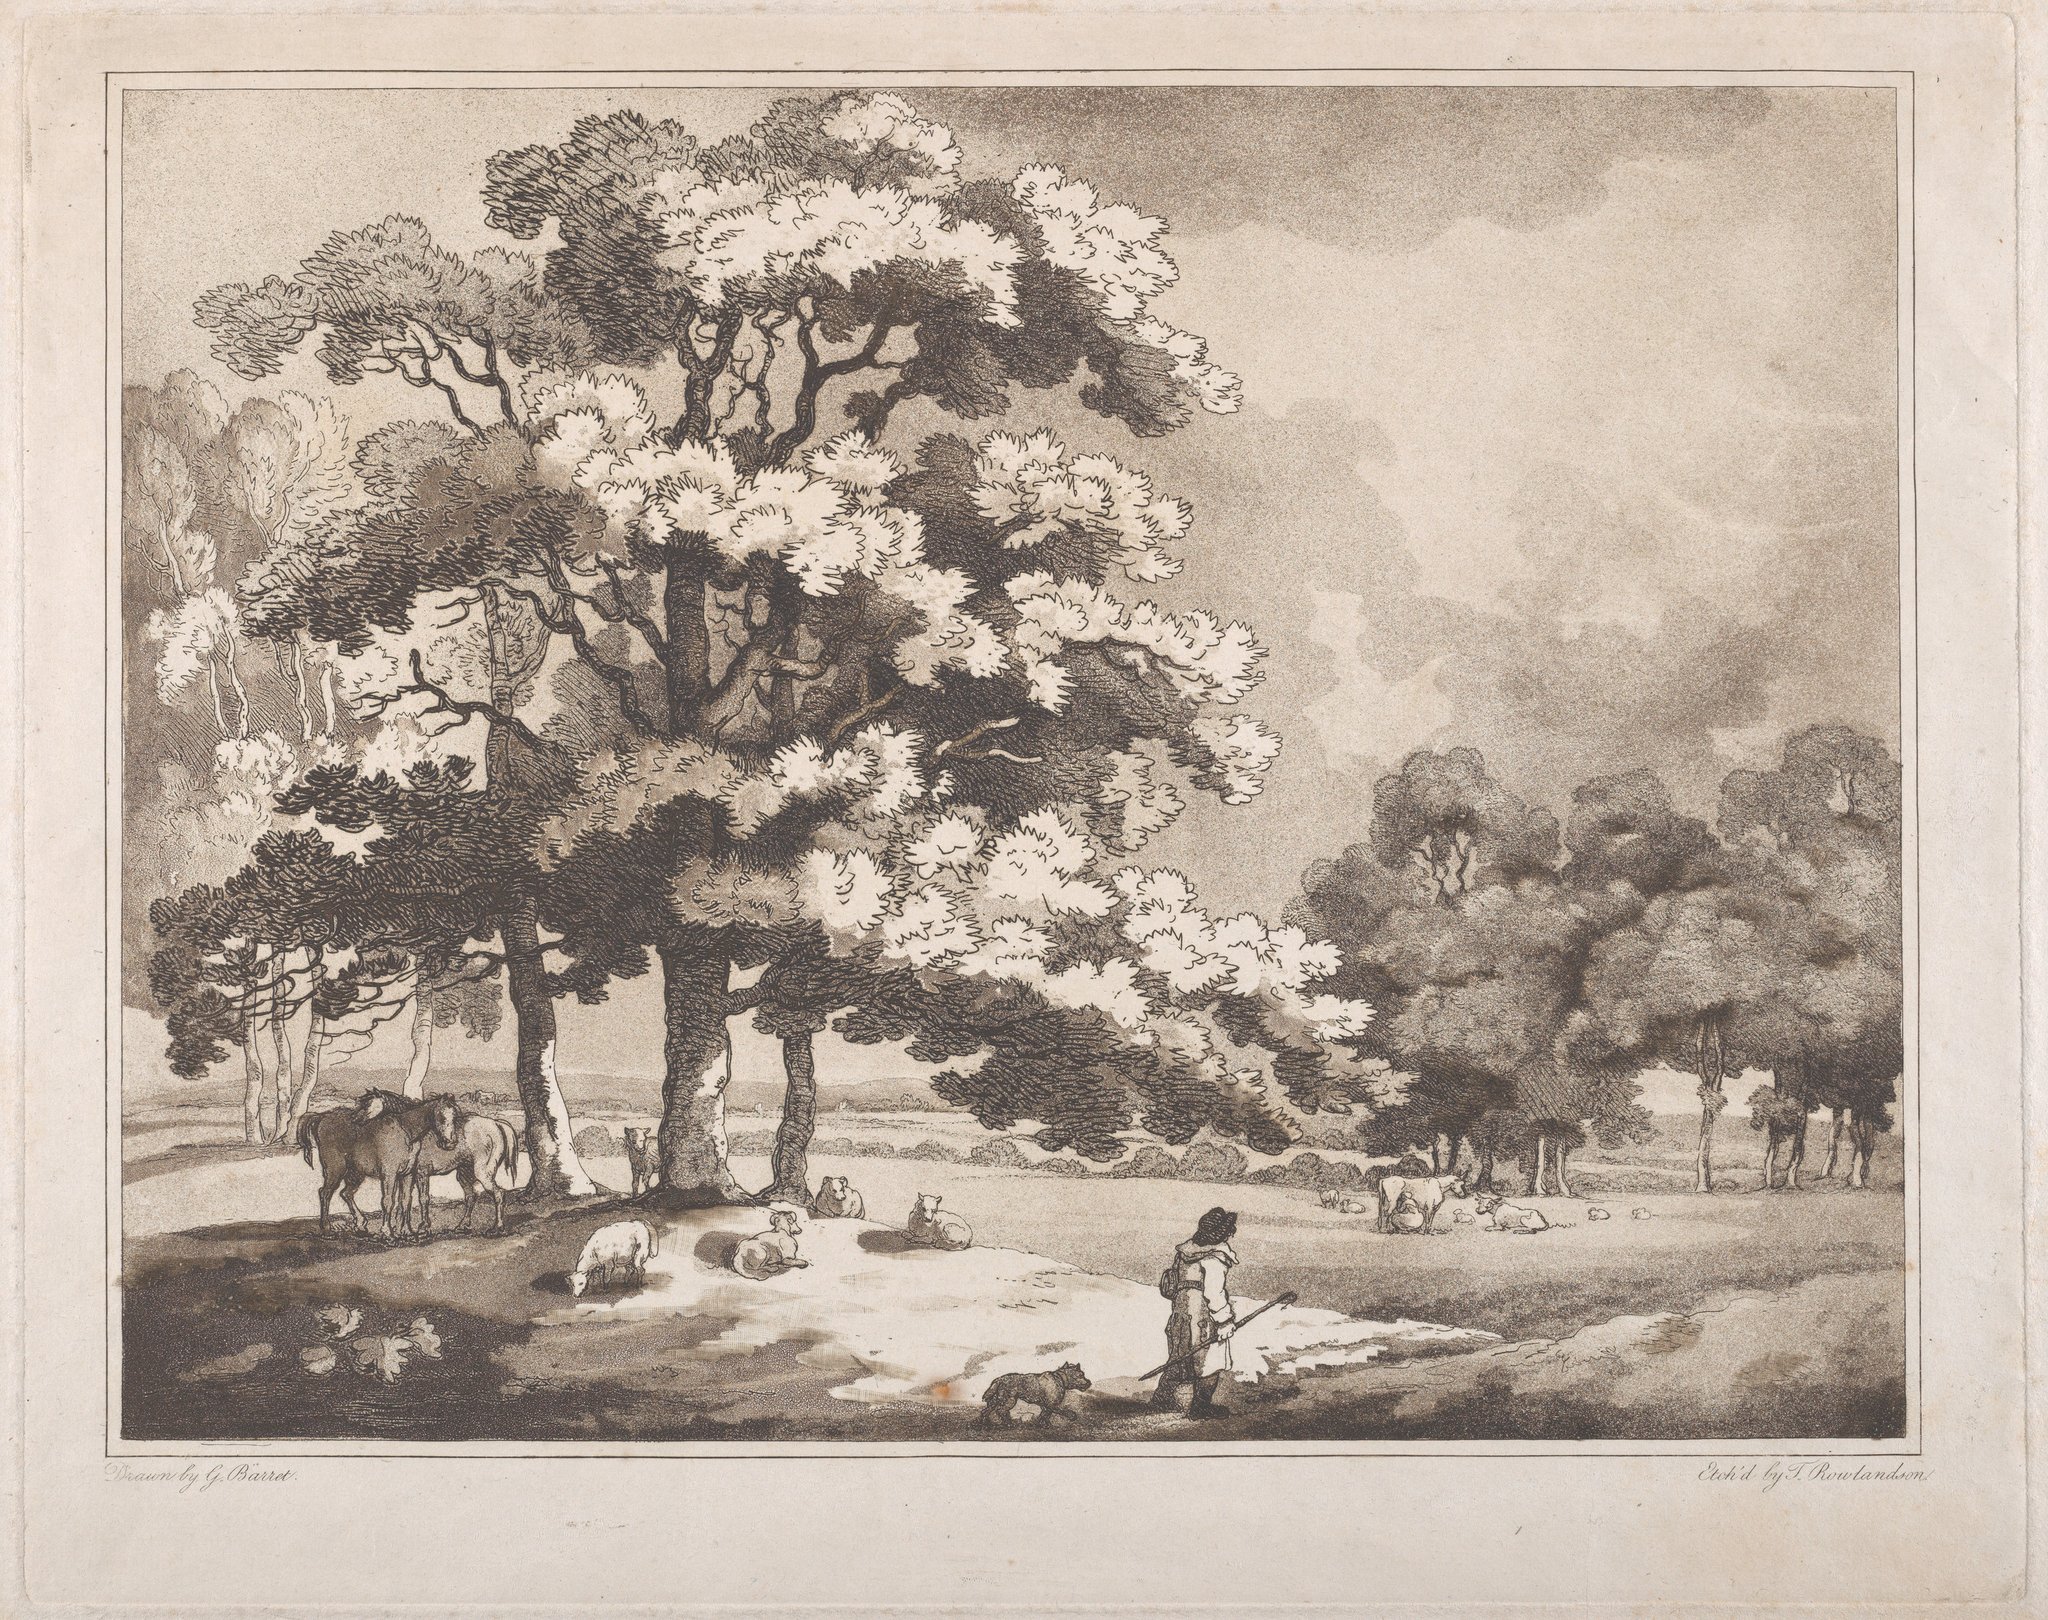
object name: print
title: A Park Landscape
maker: thomas rowlandson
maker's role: artist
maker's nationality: british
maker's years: 1757-1827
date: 1783-1789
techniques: aquatint, etching, roulette